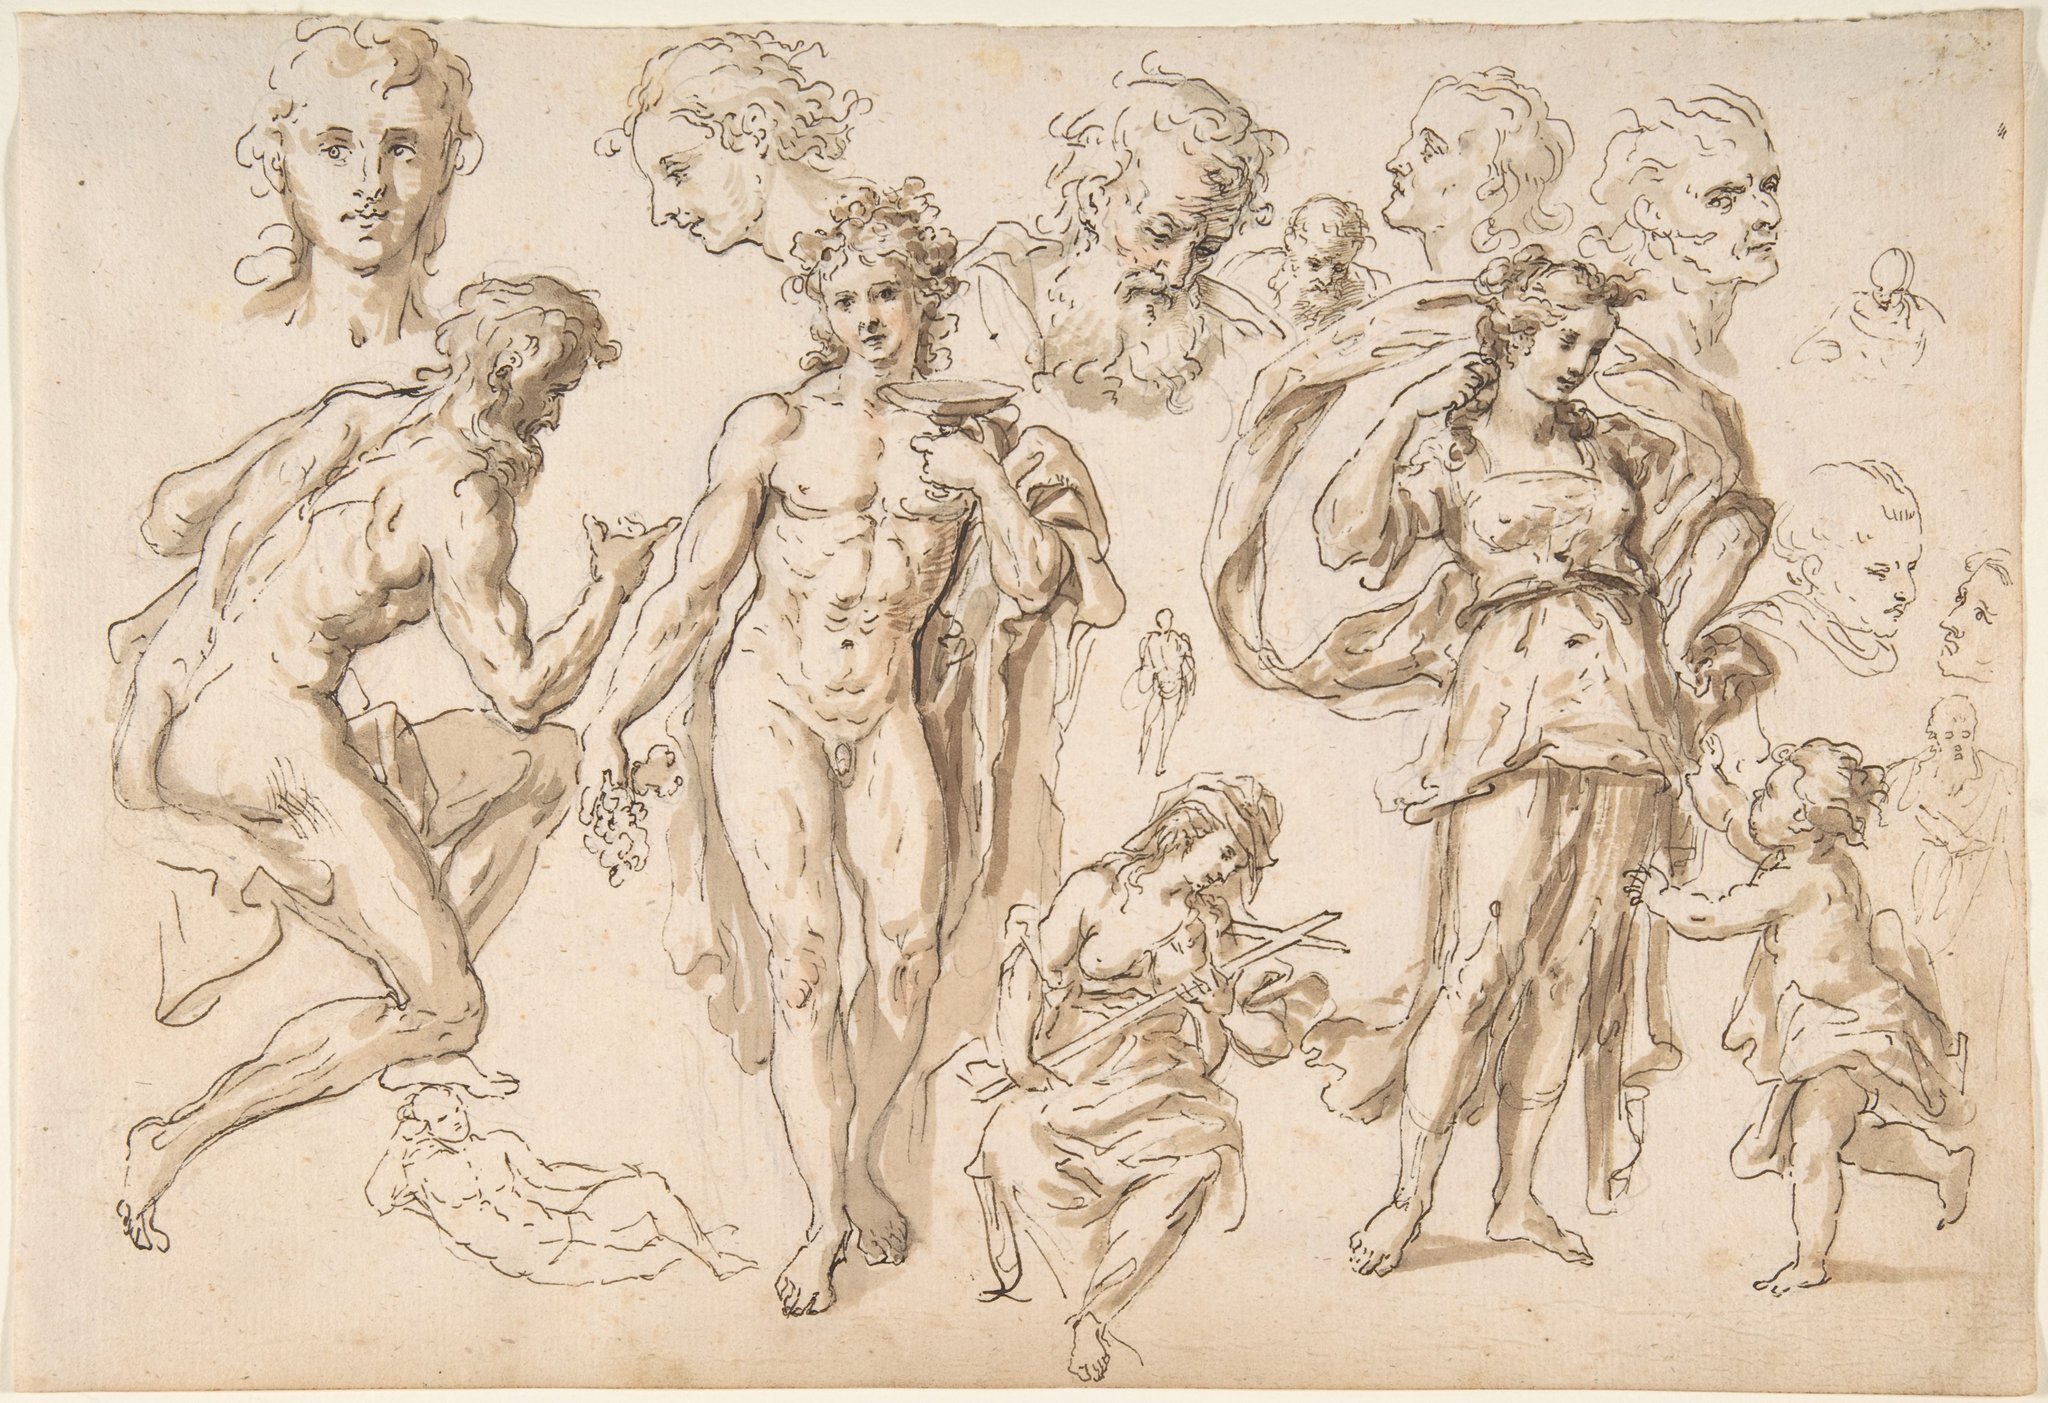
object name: drawing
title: Figure and head-studies (including Bacchus) (recto); four main figure studies repeated from the recto (verso)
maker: bartholomaeus ignaz weiss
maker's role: artist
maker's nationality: german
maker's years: 1730-1814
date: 1745-1815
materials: chalk, ink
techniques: brush, pen, wash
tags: men,male nudes,portraits,profiles,women